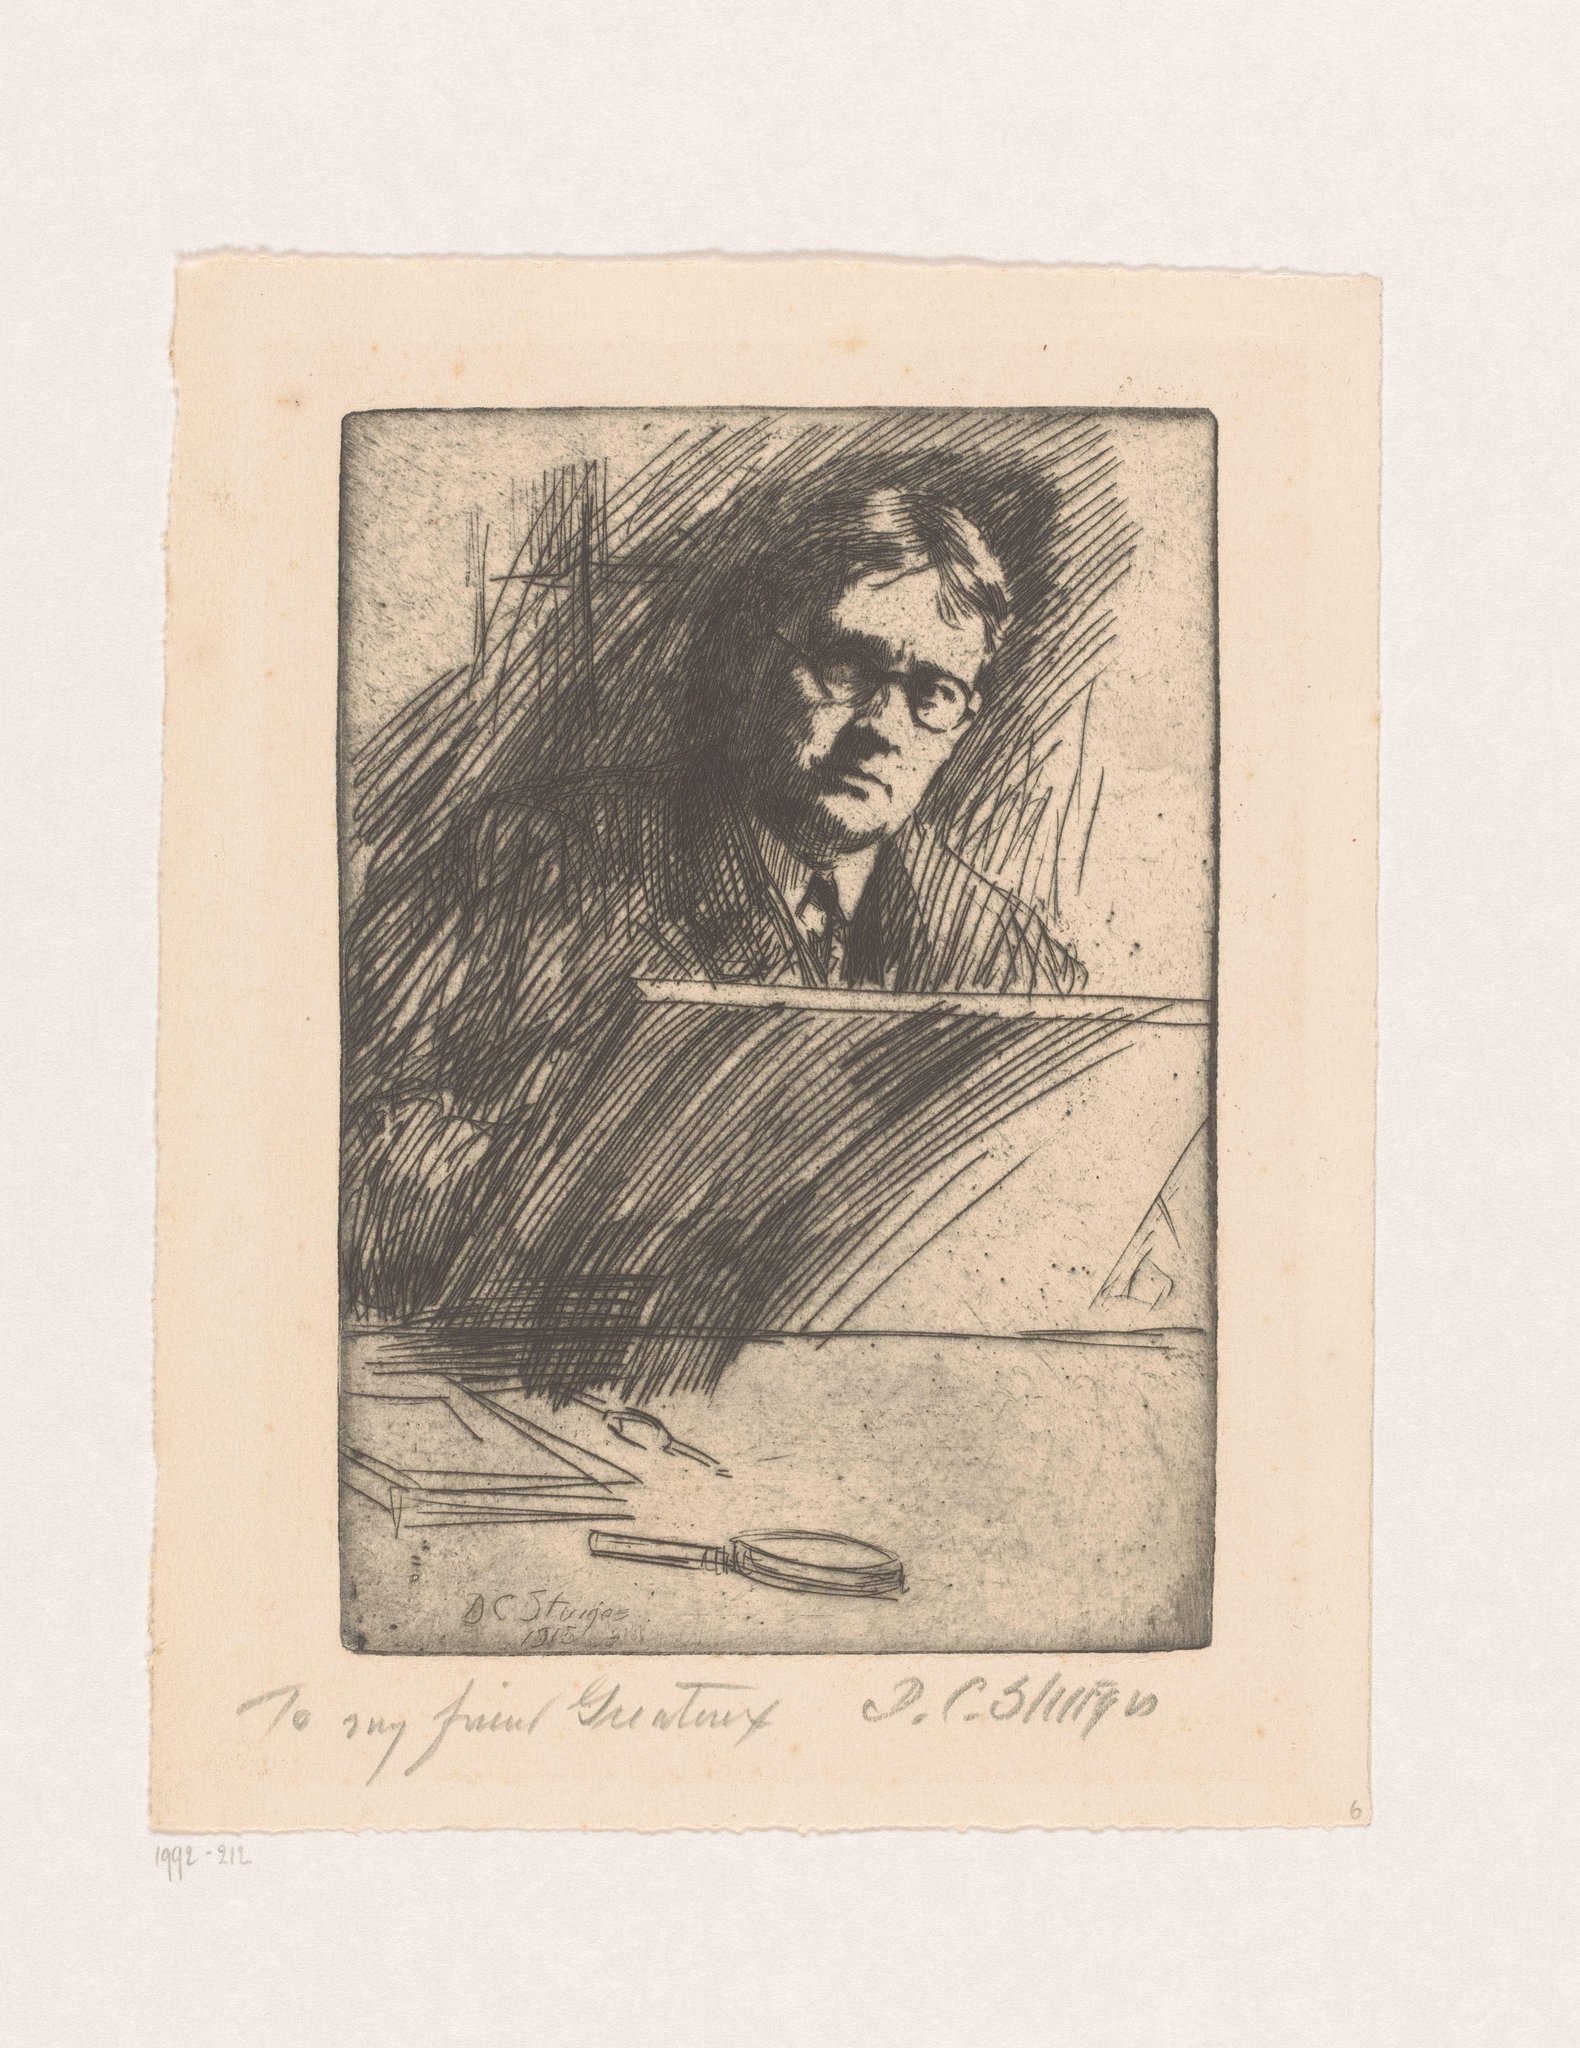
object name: print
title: Zelfportret van Dwight Case Sturges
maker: dwight case sturges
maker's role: print maker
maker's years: 1874-1940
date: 1915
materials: paper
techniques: etching, intaglio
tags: print maker, dwight case sturges, portrait, self-portrait of artist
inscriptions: collector's mark: Lugt 2228, collector's mark: Lugt 2760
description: Dwight Case Sturges achter een tekenplank aan een tafel, waarop een vergrootglas en etsinstrumenten liggen.